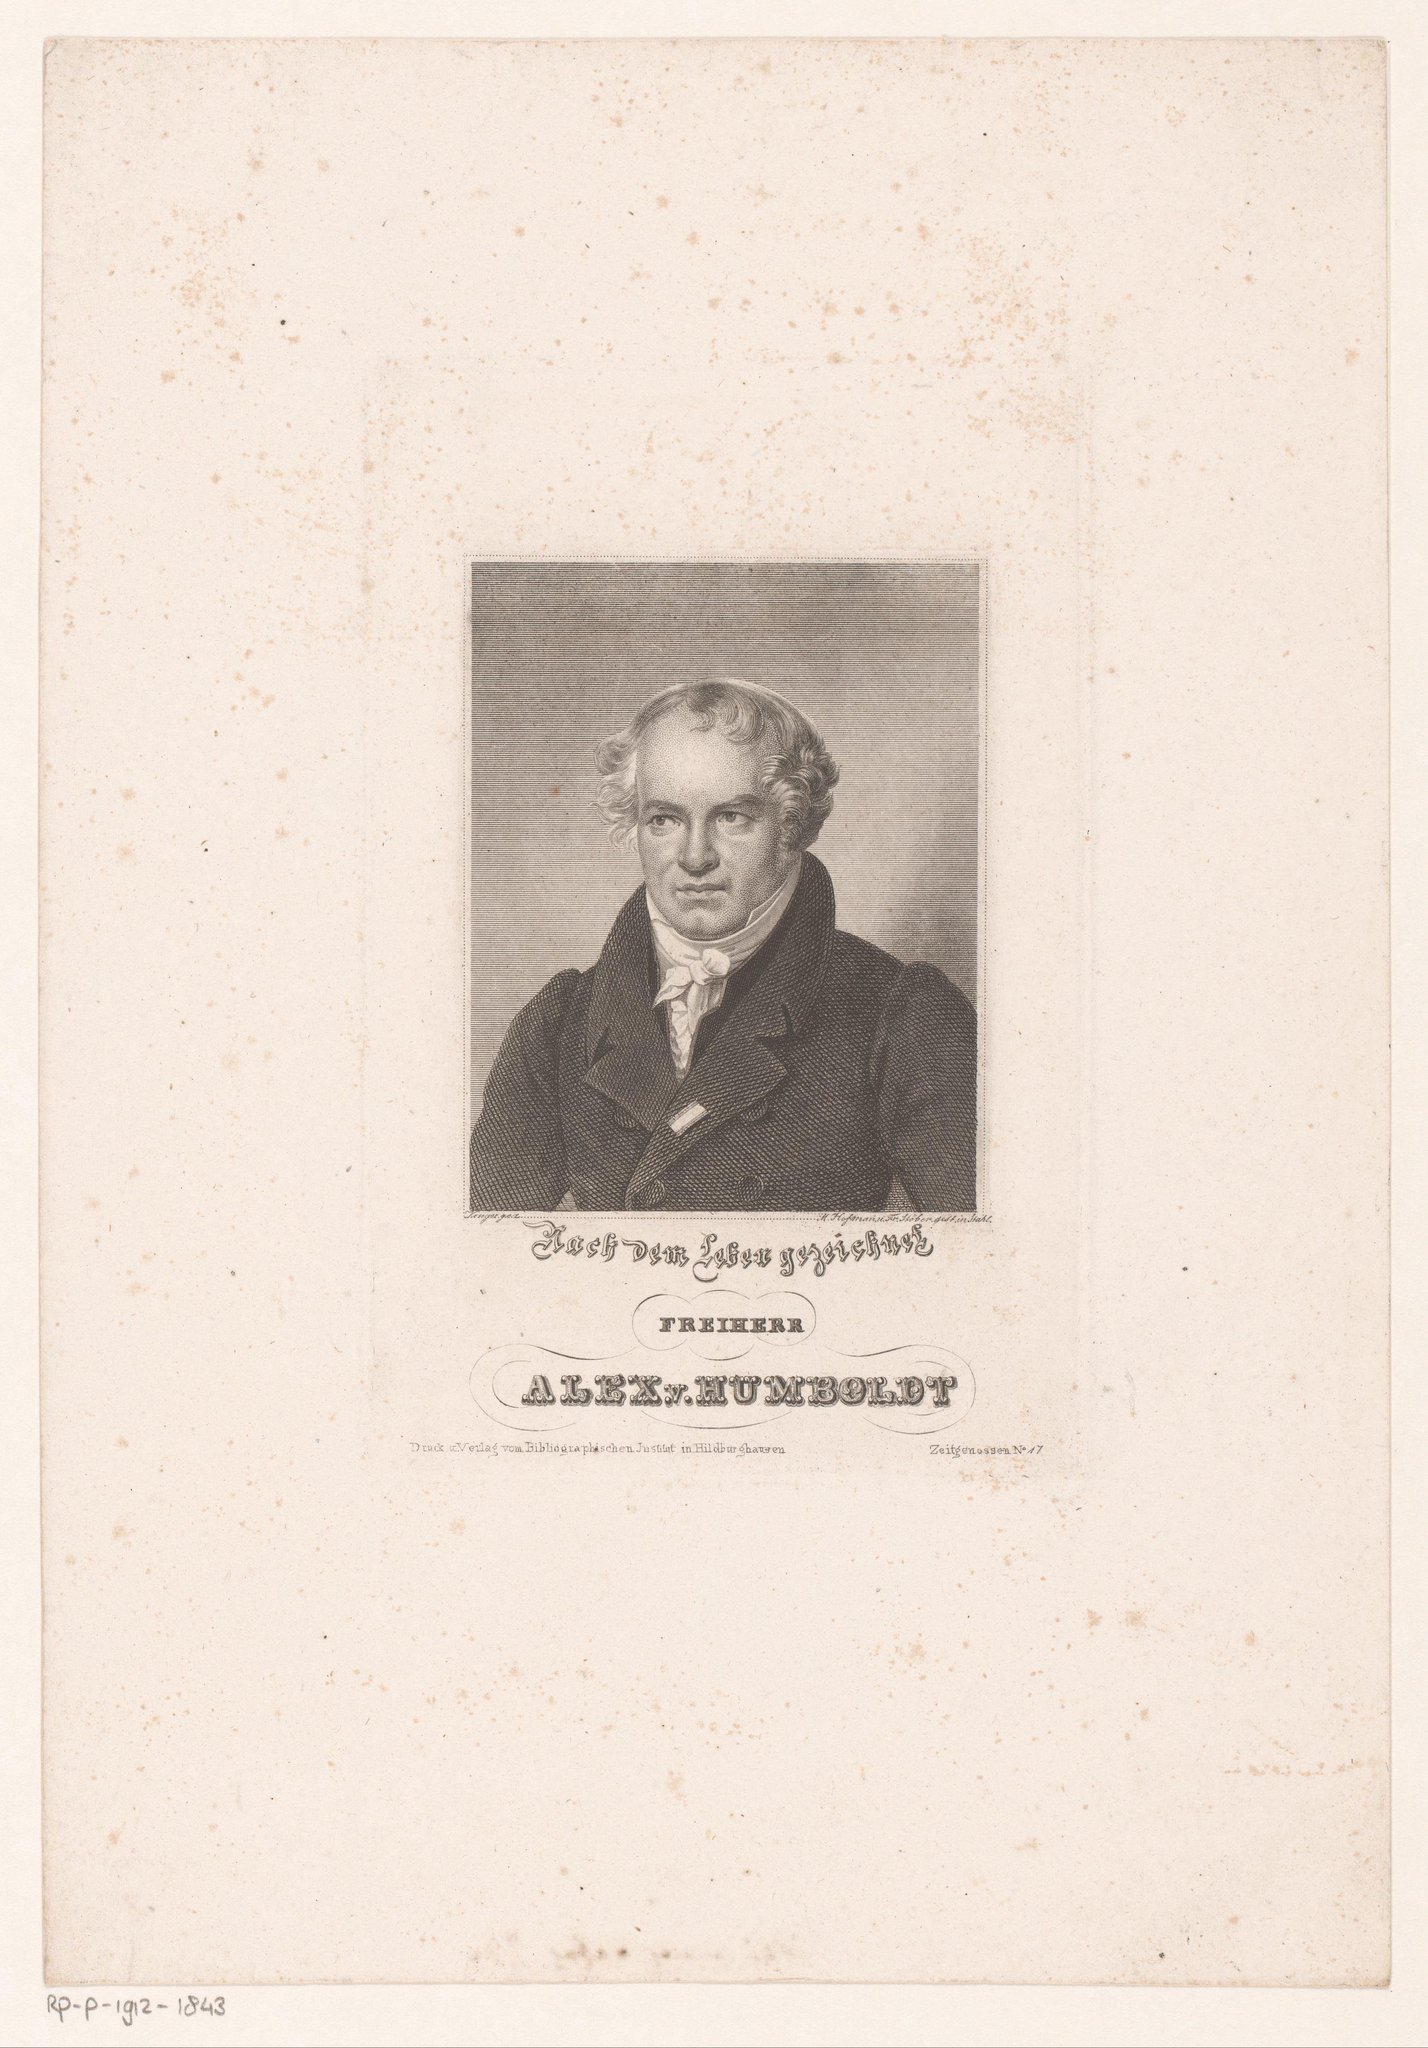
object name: print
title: Portret van Alexander von Humboldt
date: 1829-1840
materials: paper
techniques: engraving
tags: berlin, traveler, physics, historical persons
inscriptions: collector's mark: Lugt 2228